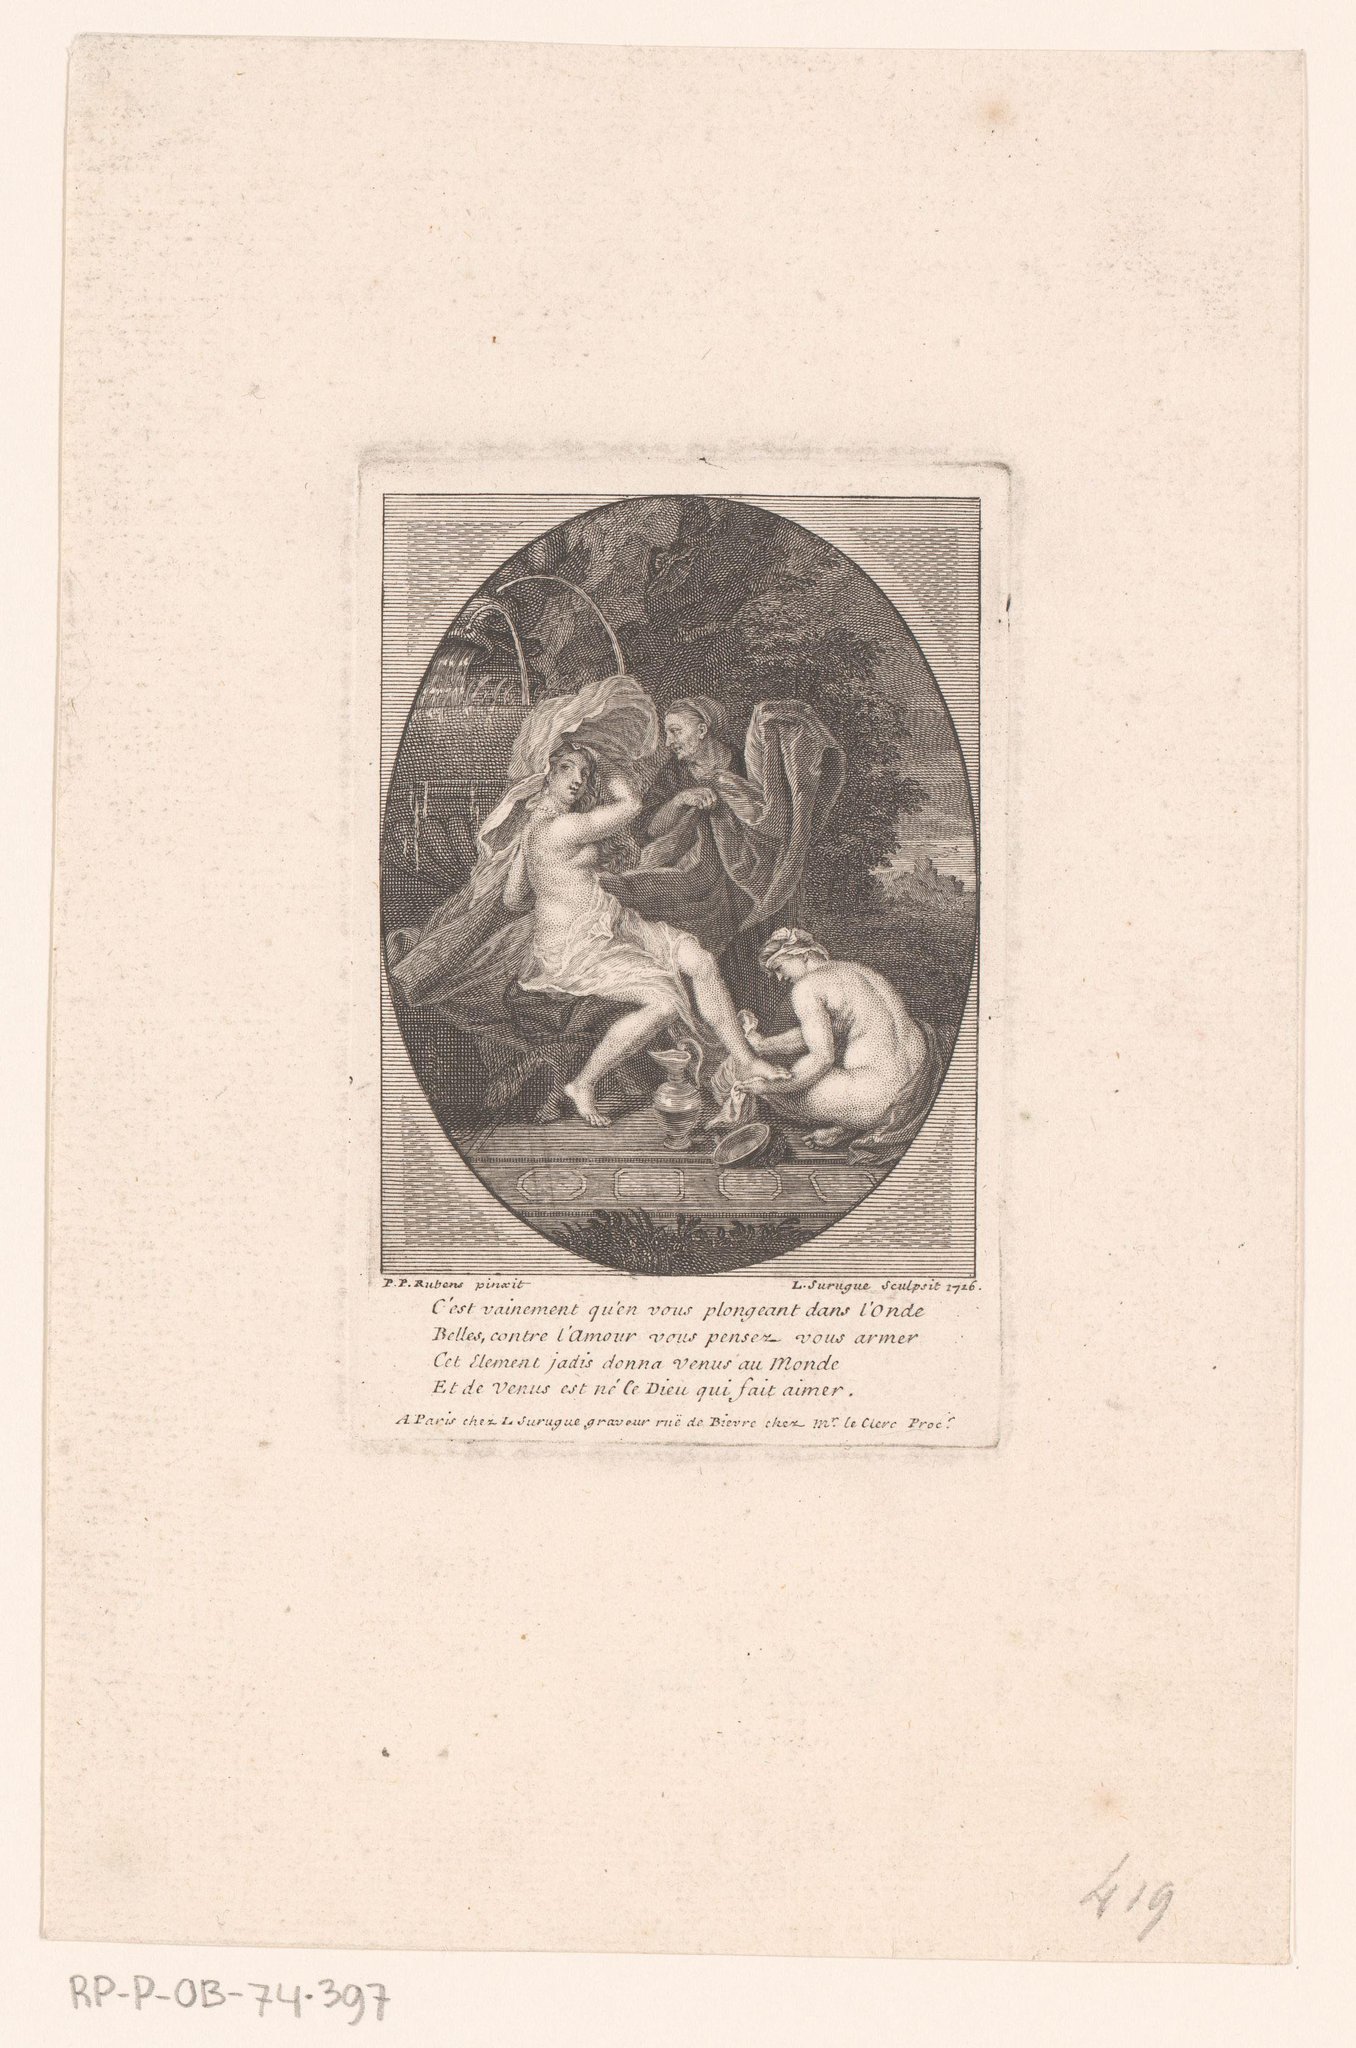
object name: print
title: Badende dame met helpsters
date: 1726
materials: paper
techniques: engraving, etching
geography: paris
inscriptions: collector's mark: Lugt 240